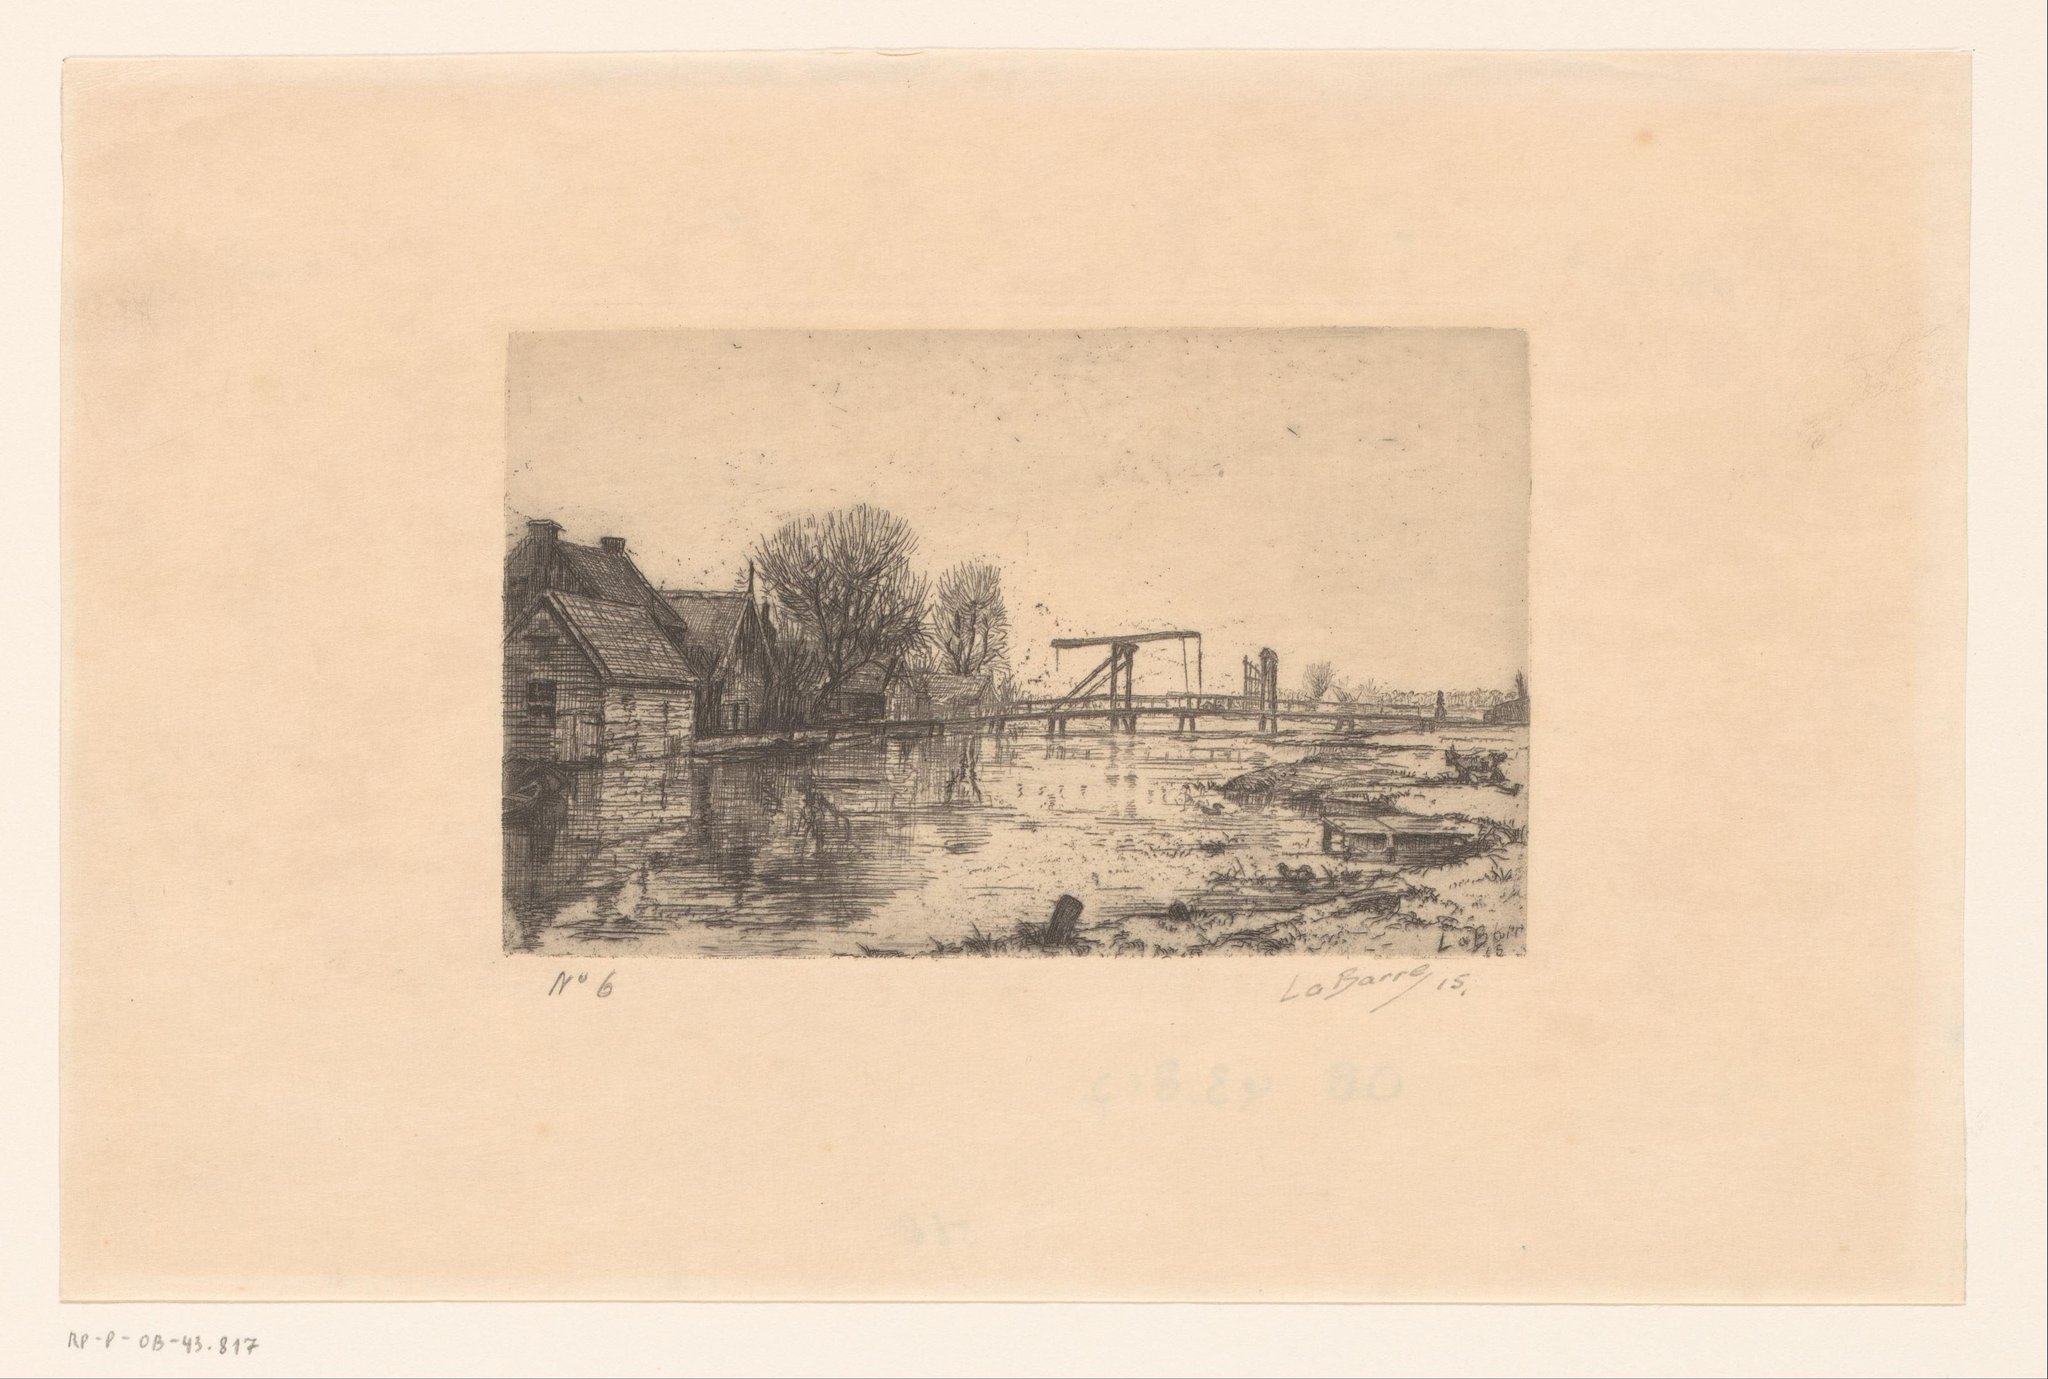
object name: print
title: Landschap met rivier en houten ophaalbrug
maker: la barre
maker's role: print maker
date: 1915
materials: paper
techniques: drypoint, etching, intaglio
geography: france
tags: bascule bridge, river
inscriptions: collector's mark: Lugt 2228